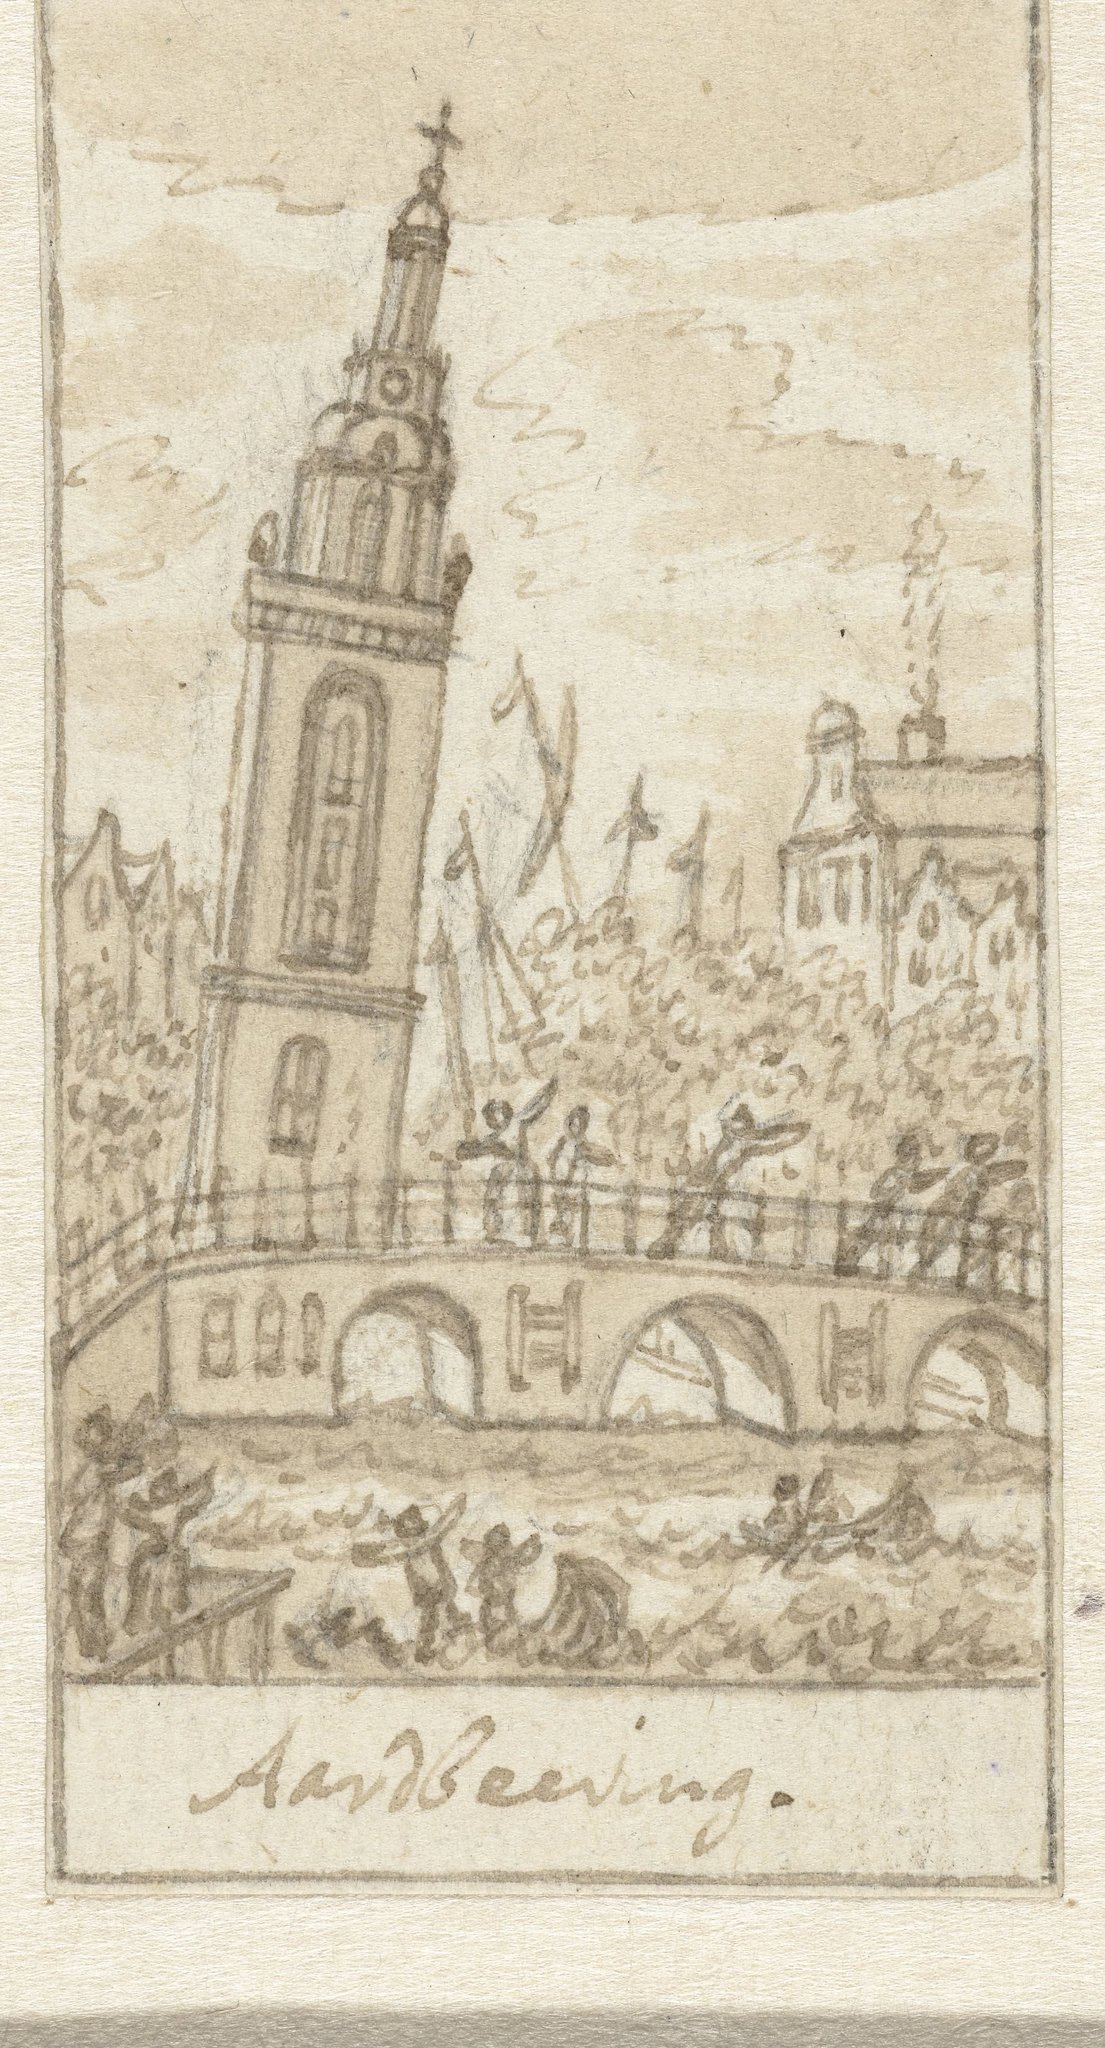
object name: drawing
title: Aardbeving: gezicht op de Oude Kerk te Amsterdam, 18 september 1692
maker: simon fokke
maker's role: draughtsman, print maker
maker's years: 1712-1784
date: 1779-1781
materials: ink, paper, pencil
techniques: brush, pen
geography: northern netherlands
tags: church (exterior), earthquake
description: Ontwerptekening voor illustratie in: Jacobus Kok, Amsteldamsche jaarboeken, behelzende de merkwaardigste geschiedenissen, welken, zo binnen de stad als daaromtrent, zijn voorgevallen, sedert haare eerste beginselen, tot op den tegenwoordigen tijd ... / Bijeengebragt door Jacobus Kok, 3 dln., J.B. Elwe, Amsterdam 1781.